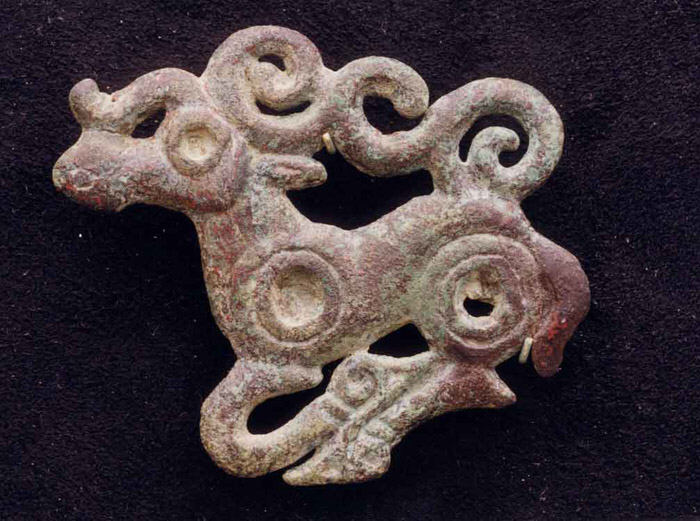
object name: garment plaque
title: Garment Plaque in the Shape of Deer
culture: kazakh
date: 600-301 BCE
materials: bronze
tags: deer